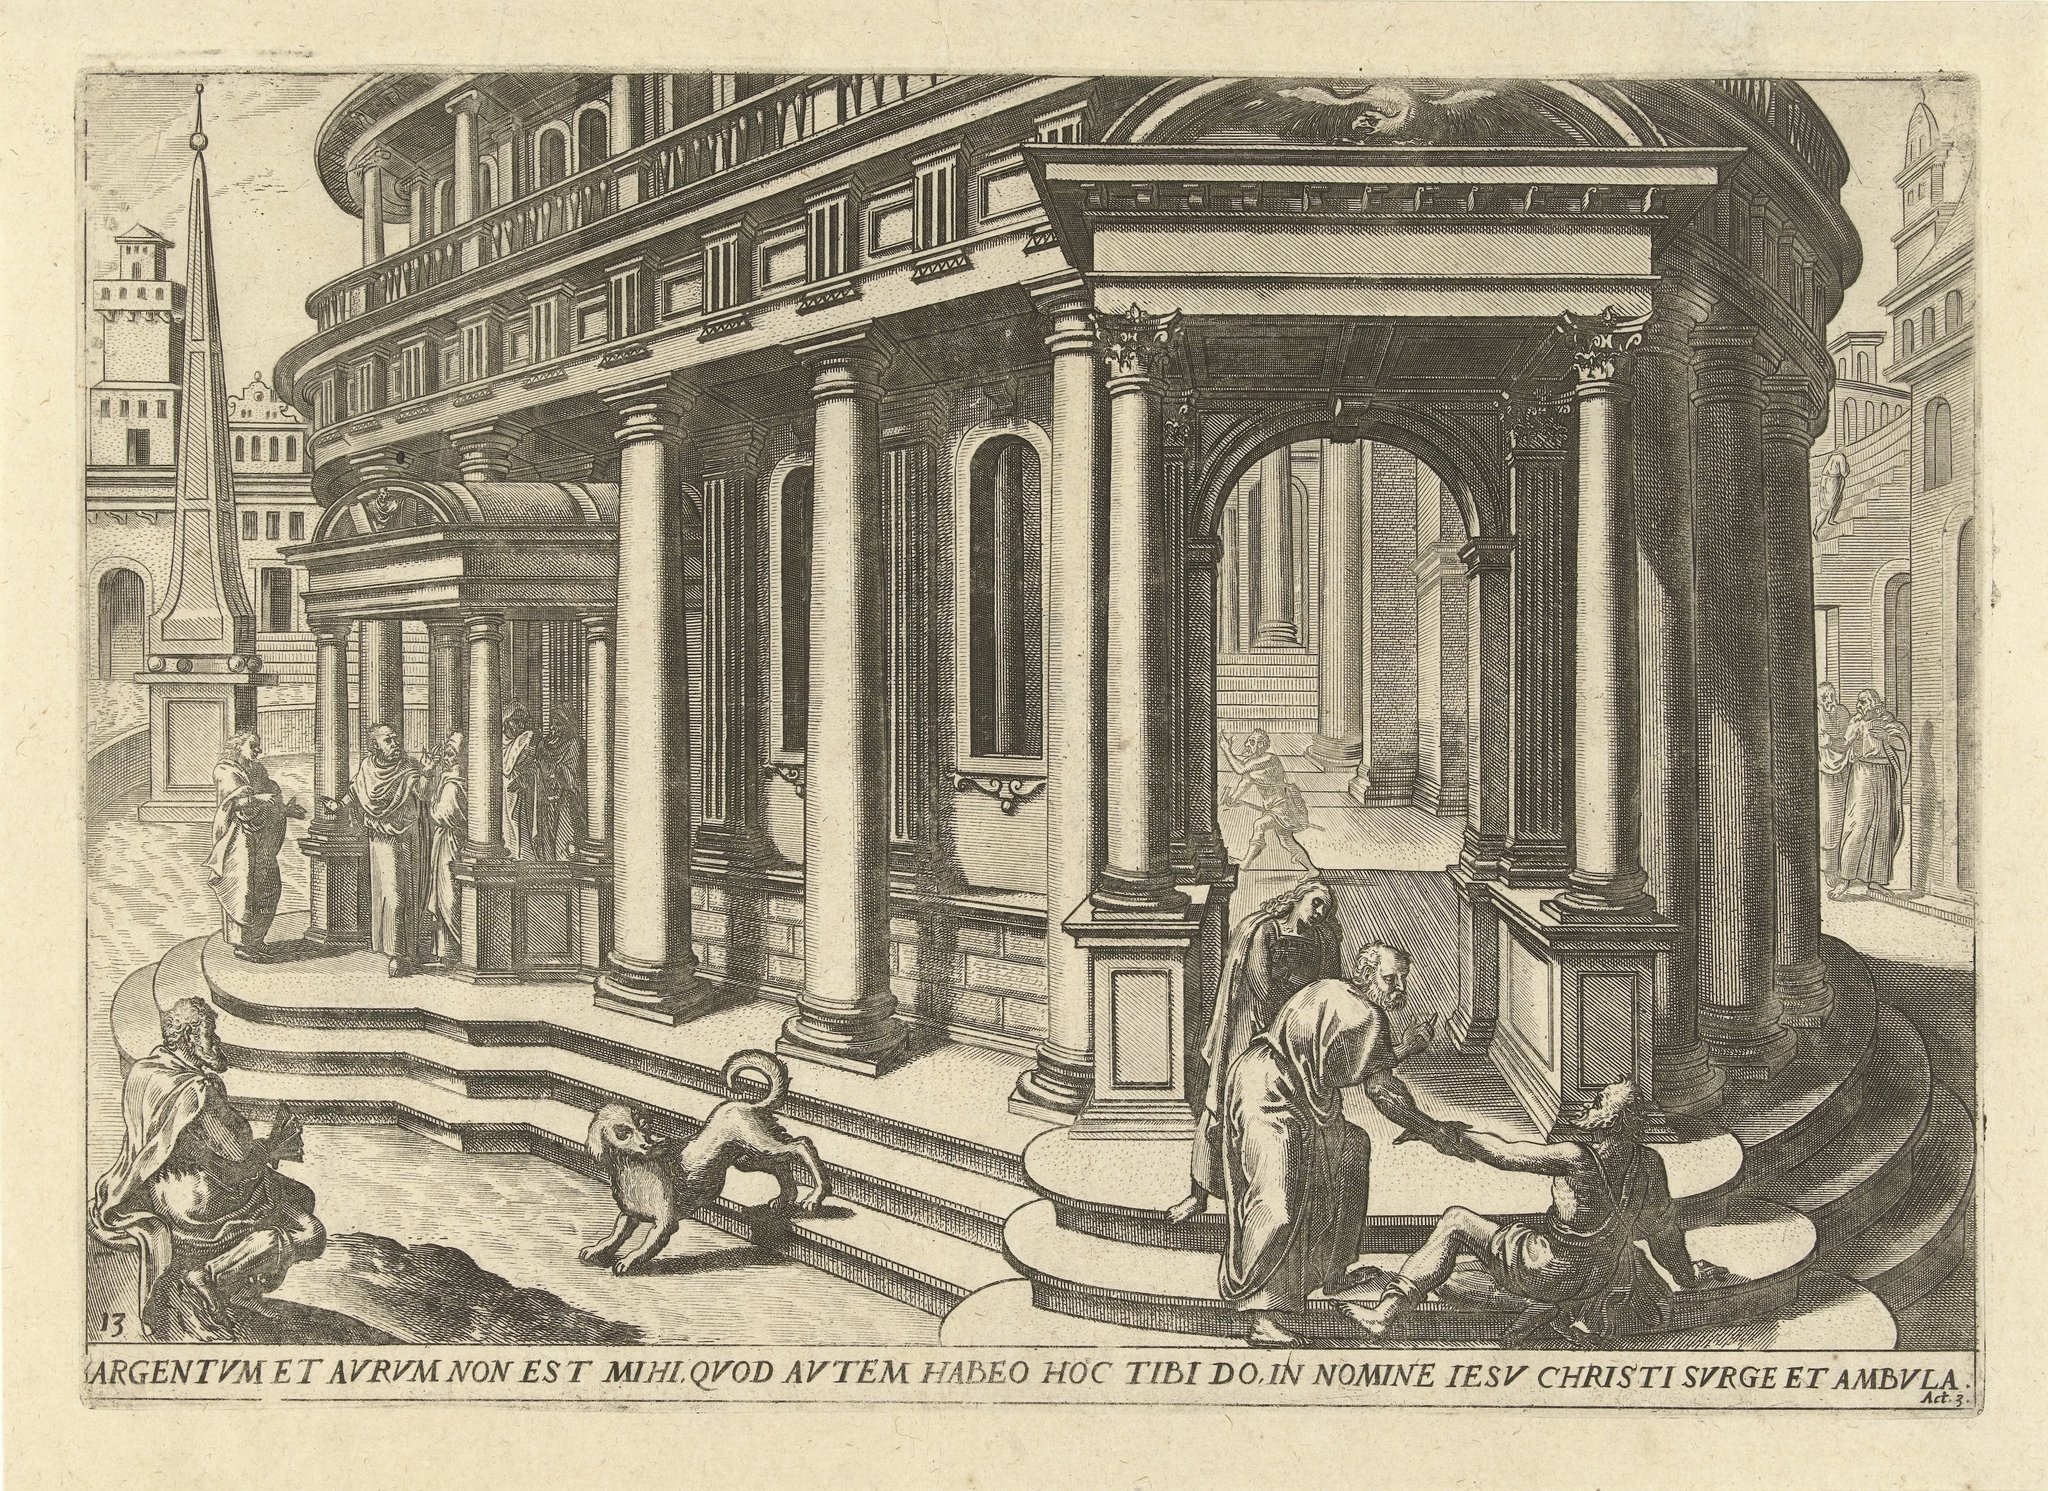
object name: print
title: Petrus en Johannes genezen een verlamde man bij de tempelpoort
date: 1572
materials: paper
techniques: engraving, etching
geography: antwerp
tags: healing of a lame beggar at the beautiful gate of the temple by peter and john (acts 3 - 4:31), disabilities, deformations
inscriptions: collector's mark: Lugt 2228, collector's mark: Lugt 2760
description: De voorstelling is gebaseerd op de tekst uit Handelingen 3:4-31. In de Statenvertaling is de bedelaar beschreven als: “En een zeker man, die kreupel was van zijner moeders lijf, werd gedragen, welken zij dagelijks zetten aan de deur des tempels (…) Maar Petrus zei (…) In den Naam van Jezus Christus den Nazaréner, sta op en wandel. En hem grijpende bij de rechterhand, richtte hij hem op, en terstond werden zijn voeten en enkels vast”. In de Nieuwe Bijbelvertaling wordt er niet gesproken over ‘kreupel’ maar over verlamming: “Men had ook een man die al sinds zijn geboorte verlamd was naar de tempel gebracht (…) Maar Petrus zei (…) in de naam van Jezus Christus van Nazareth, sta op en loop.’ Hij pakte hem bij zijn rechterhand om hem overeind te helpen. Onmiddellijk kwam er kracht in zijn voeten en enkels.”